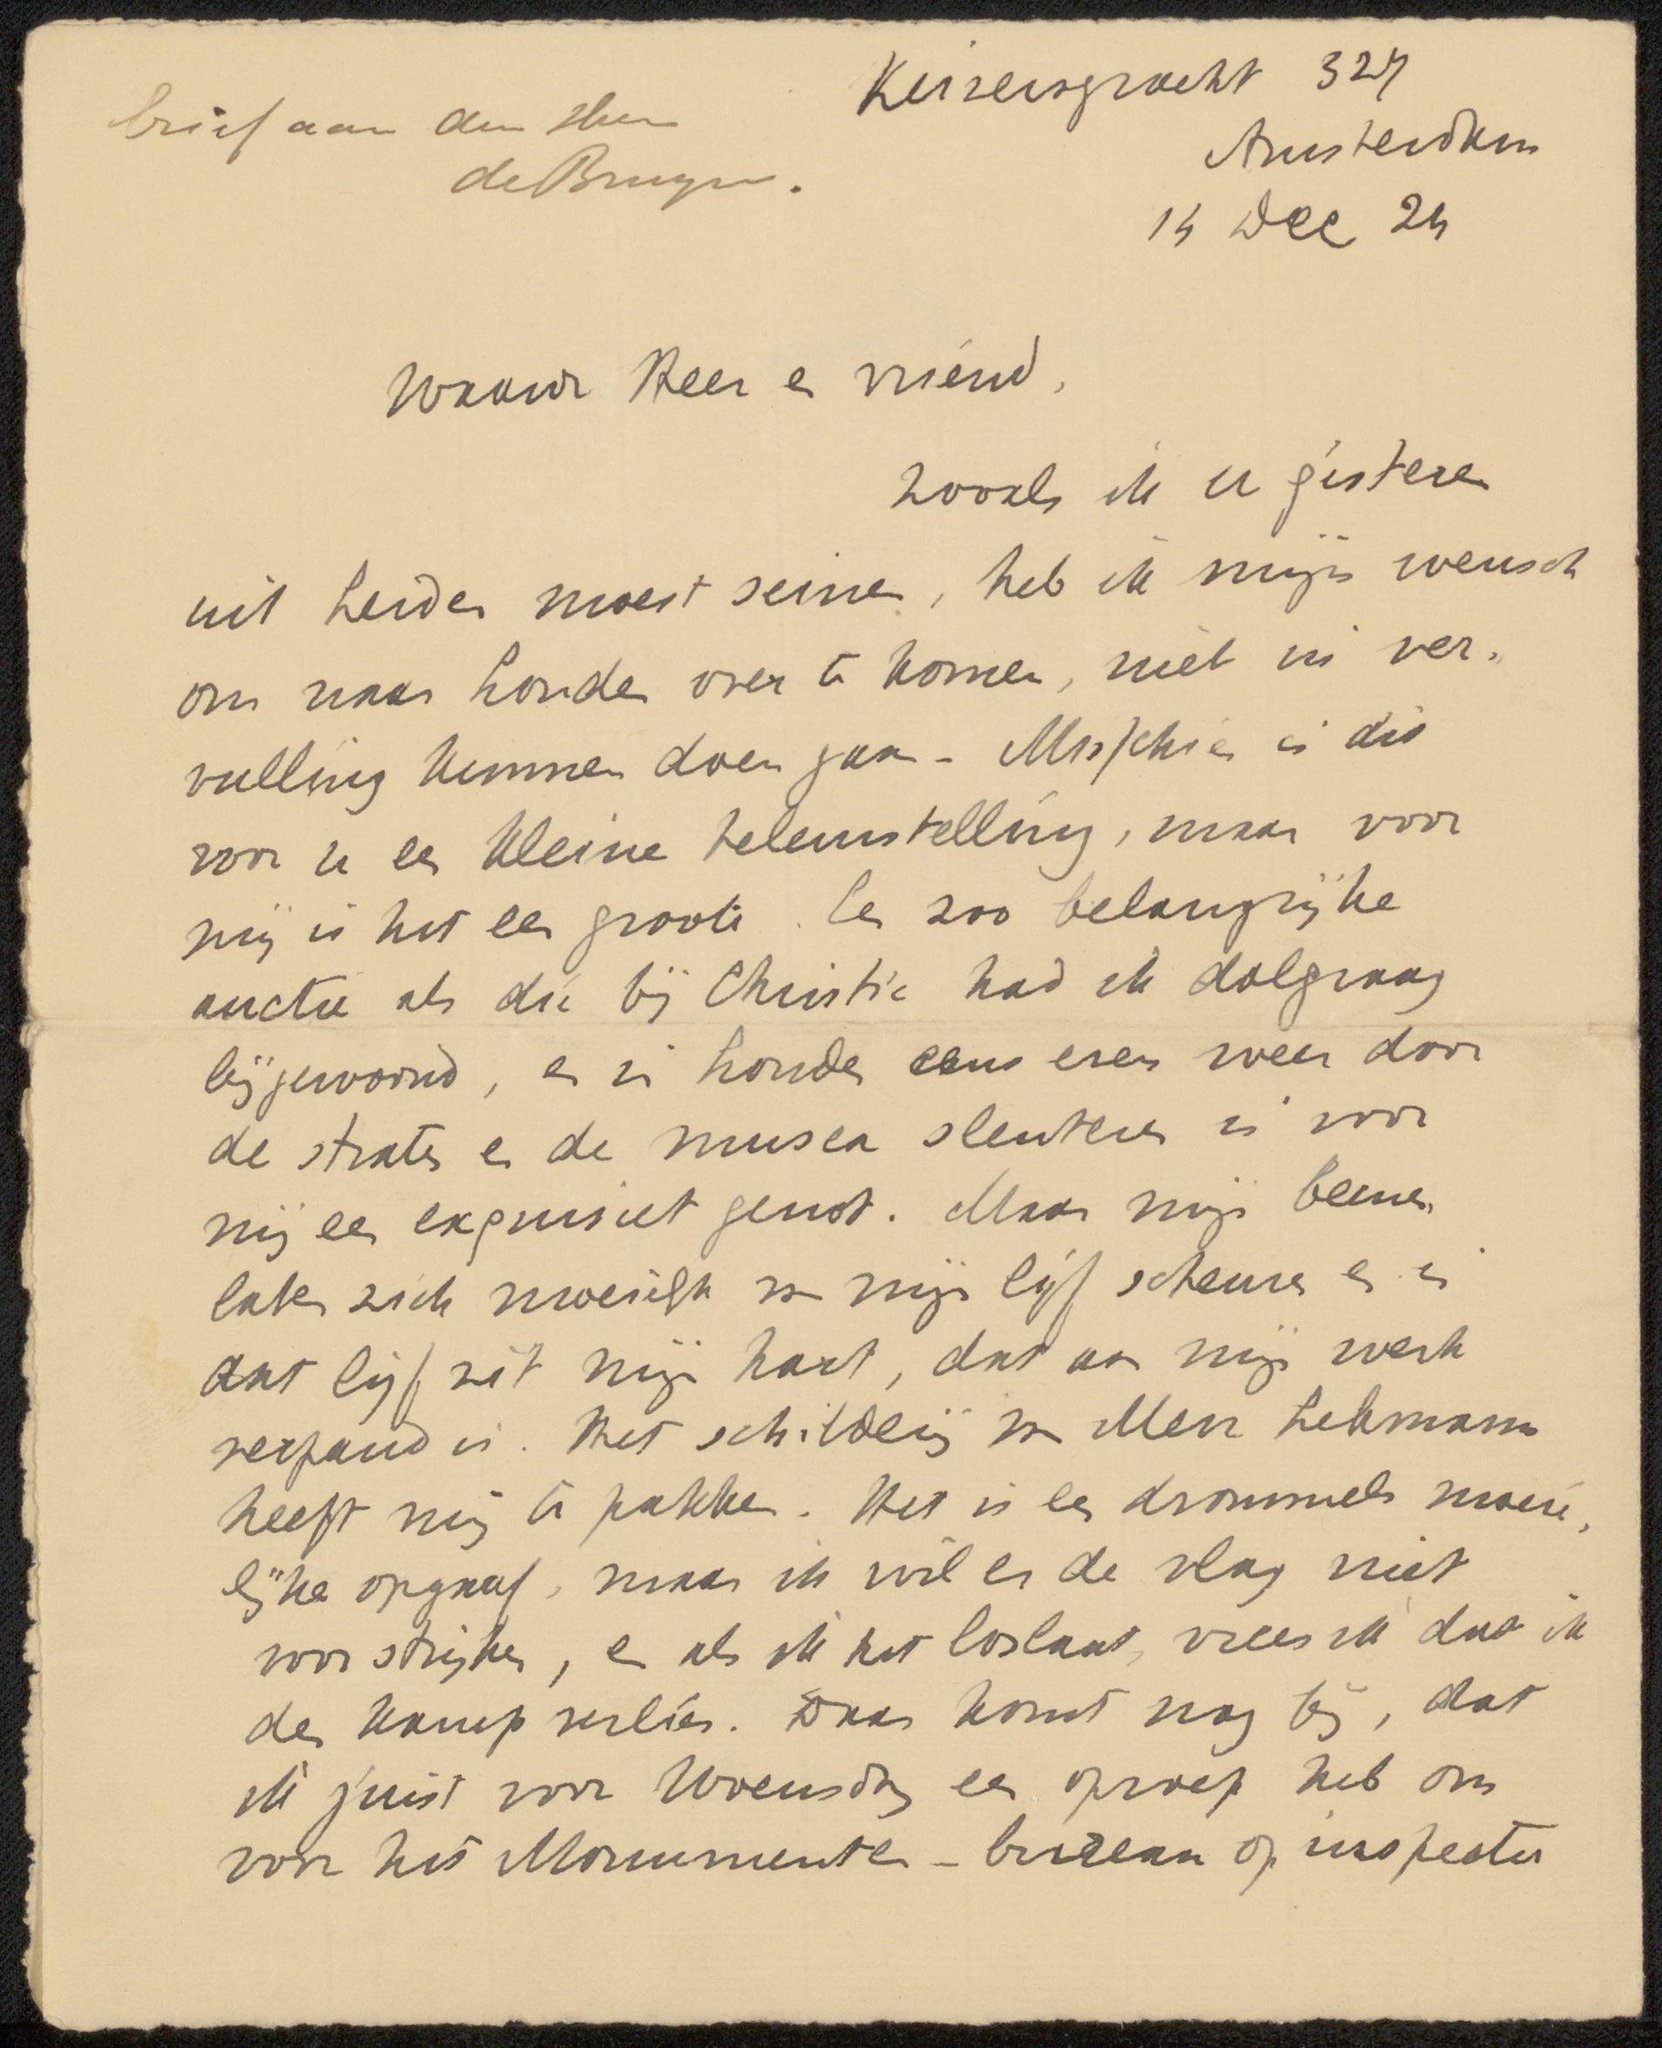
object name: letter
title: Brief aan Isaäc de Bruijn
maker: jan veth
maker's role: designer, draughtsman, painter, print maker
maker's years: 1864-1925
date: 1924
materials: ink, paper, pencil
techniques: pen, writing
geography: amsterdam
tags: art trade, art shop, painting (including book-illumination, miniature-painting), leiden, london, den bosch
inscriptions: collector's mark: ‘RPK’